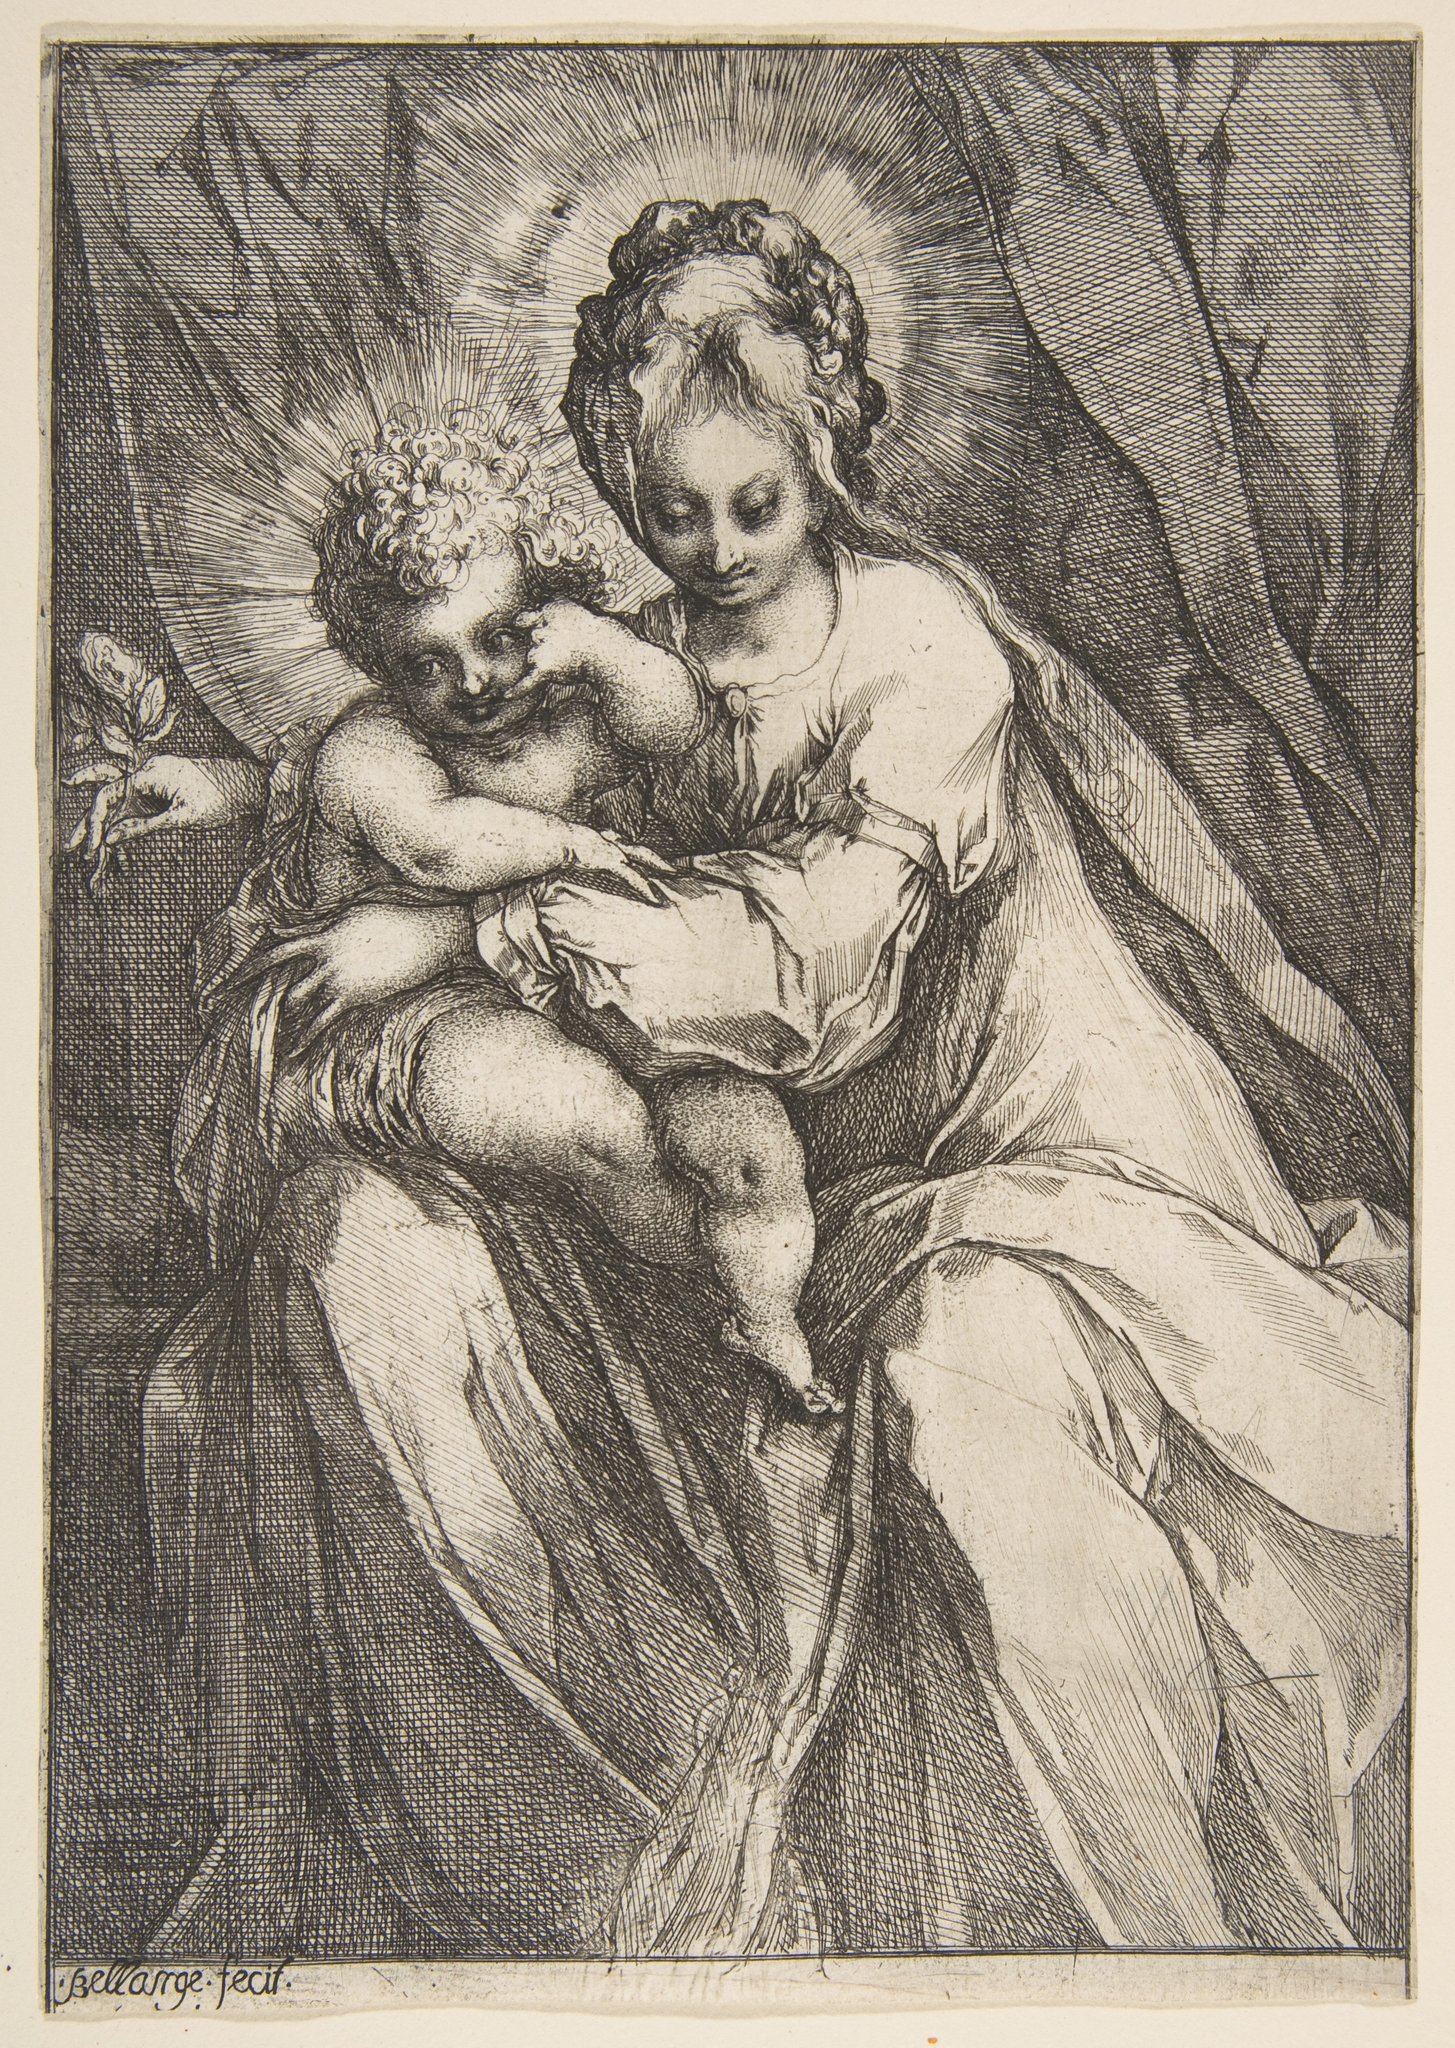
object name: print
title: Madonna with a Rose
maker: jacques bellange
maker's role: artist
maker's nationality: french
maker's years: 1575-1616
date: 1595-1616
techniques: etching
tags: roses,madonna and child